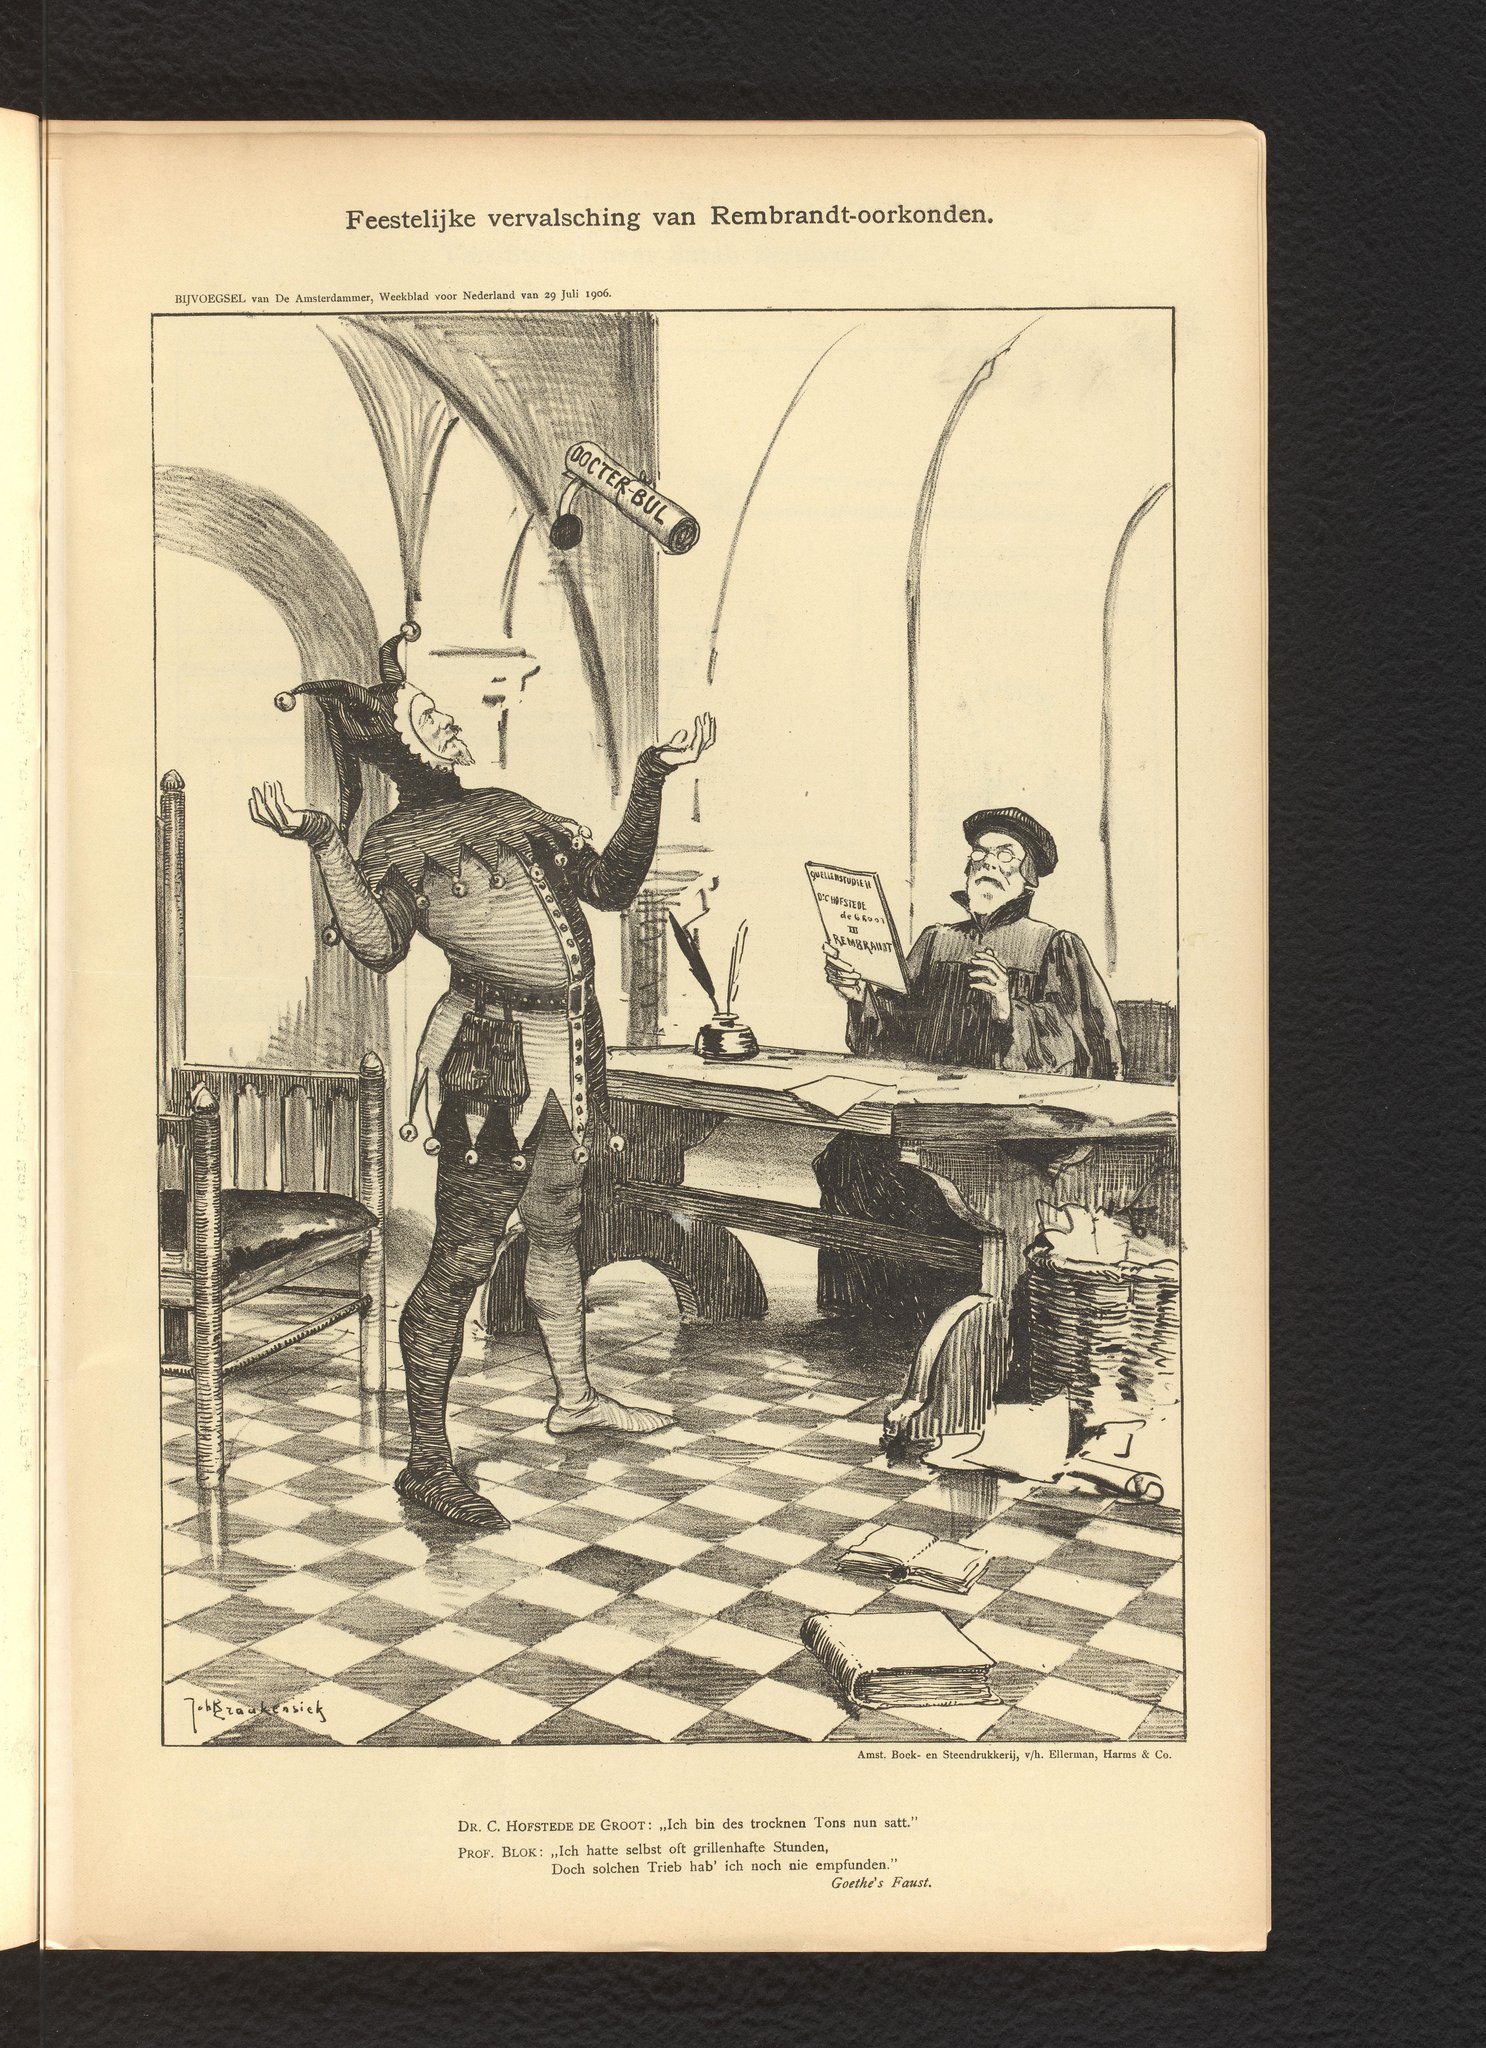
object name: cartoon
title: Feestelijke vervalsching van Rembrandt-oorkonden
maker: johan braakensiek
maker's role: draughtsman, print maker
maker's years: 1858-1940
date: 1906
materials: paper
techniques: lithograph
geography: netherlands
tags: den helder, leiden, the hague, cornelis hofstede de groot, court jester, court fool, illusionist, conjurer, juggler, 'legerdemain', university diploma, political caricatures and satires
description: Historicus professor Petrus Johannes Blok als een nar die jongleert met een doctorsbul tegenover de geleerde kunsthistoricus Cornelis Hofstede de Groot. Naar een scène uit Goethe's Faust.